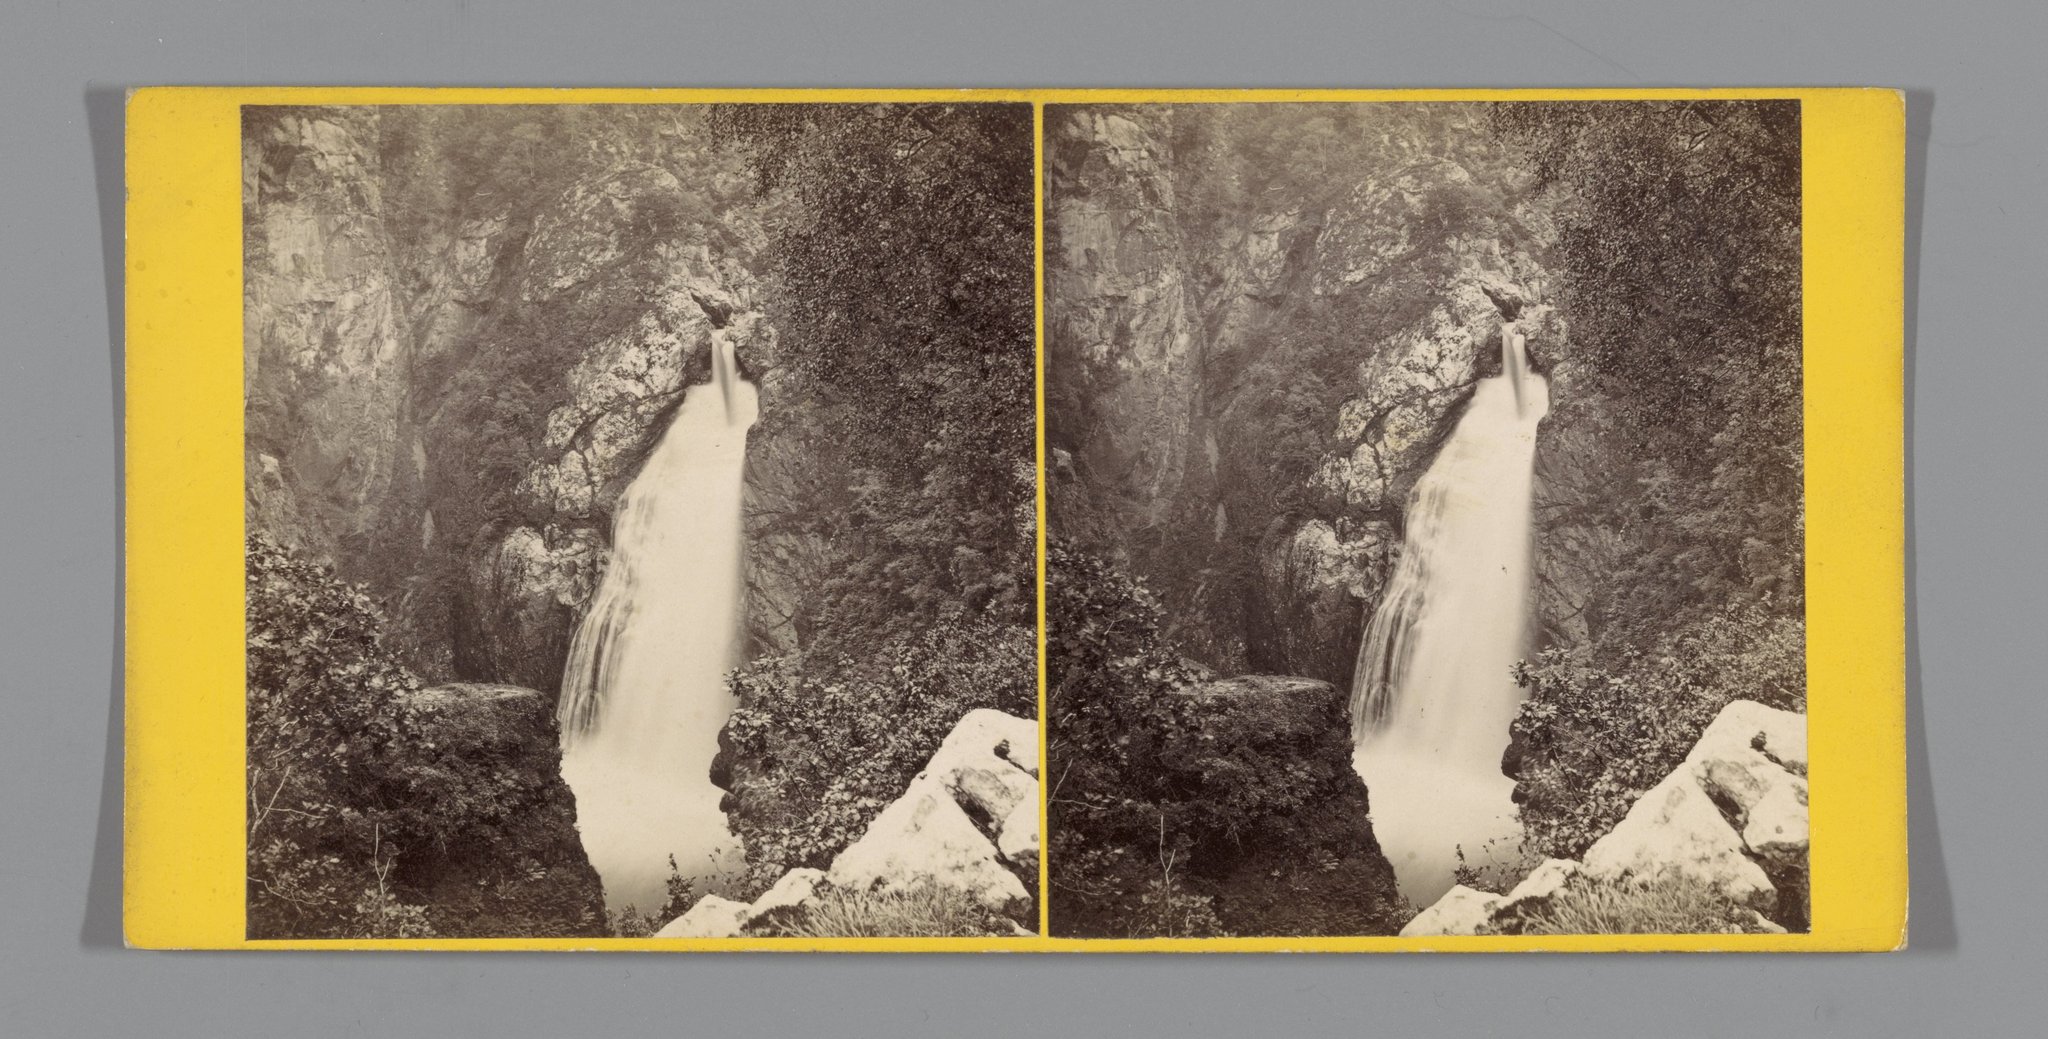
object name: stereograph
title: Fall of Foyers, Inverness-shire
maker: george washington wilson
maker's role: publisher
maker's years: 1823-1893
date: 1850-1880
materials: cardboard, photographic support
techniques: albumen print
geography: highland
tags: waterfall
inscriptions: name: ‘Registered G. W. Wilson, Photographer, Aberdeen.’, number: ‘No. 148.’